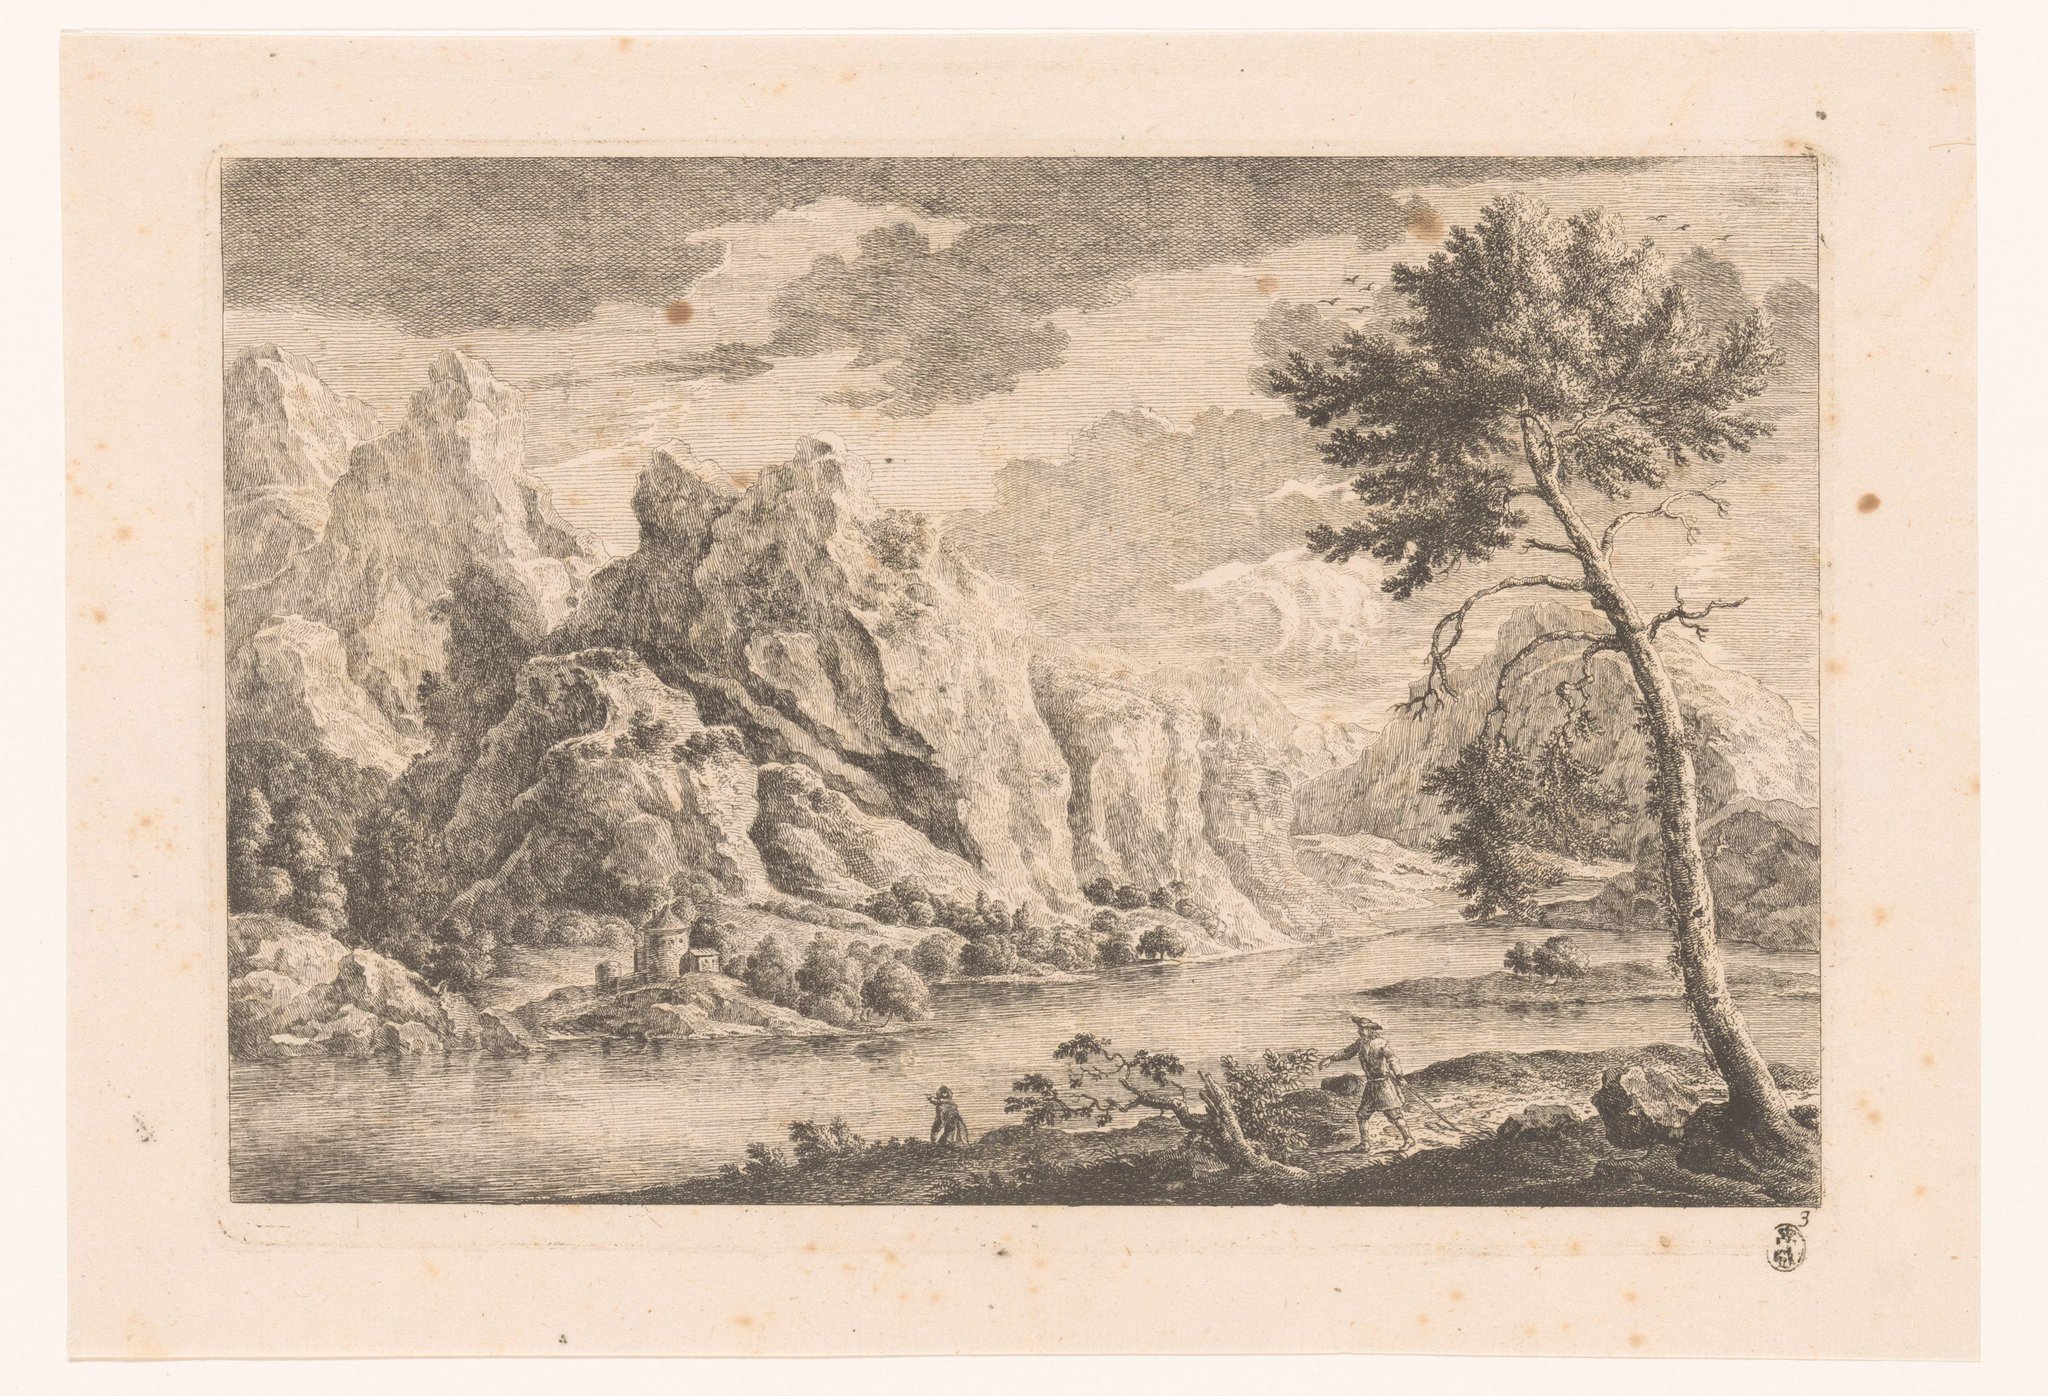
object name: print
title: Berglandschap met rivier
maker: monogrammist meg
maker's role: print maker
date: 1700-1730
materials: paper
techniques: etching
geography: germany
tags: river, landscapes in the temperate zone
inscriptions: collector's mark: Lugt 2228, collector's mark: Lugt 2760, collector's mark: Lugt 971